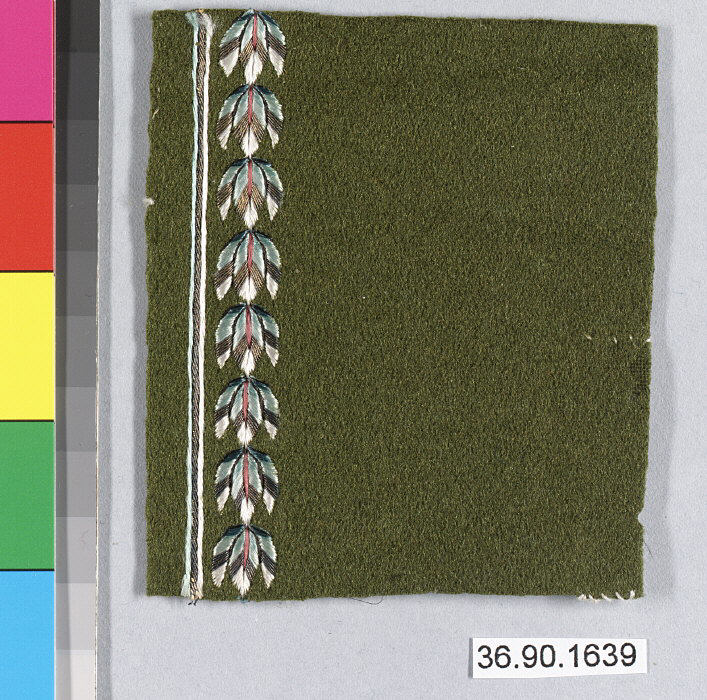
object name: sample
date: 1801-1833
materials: felt, metal thread, silk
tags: leaves